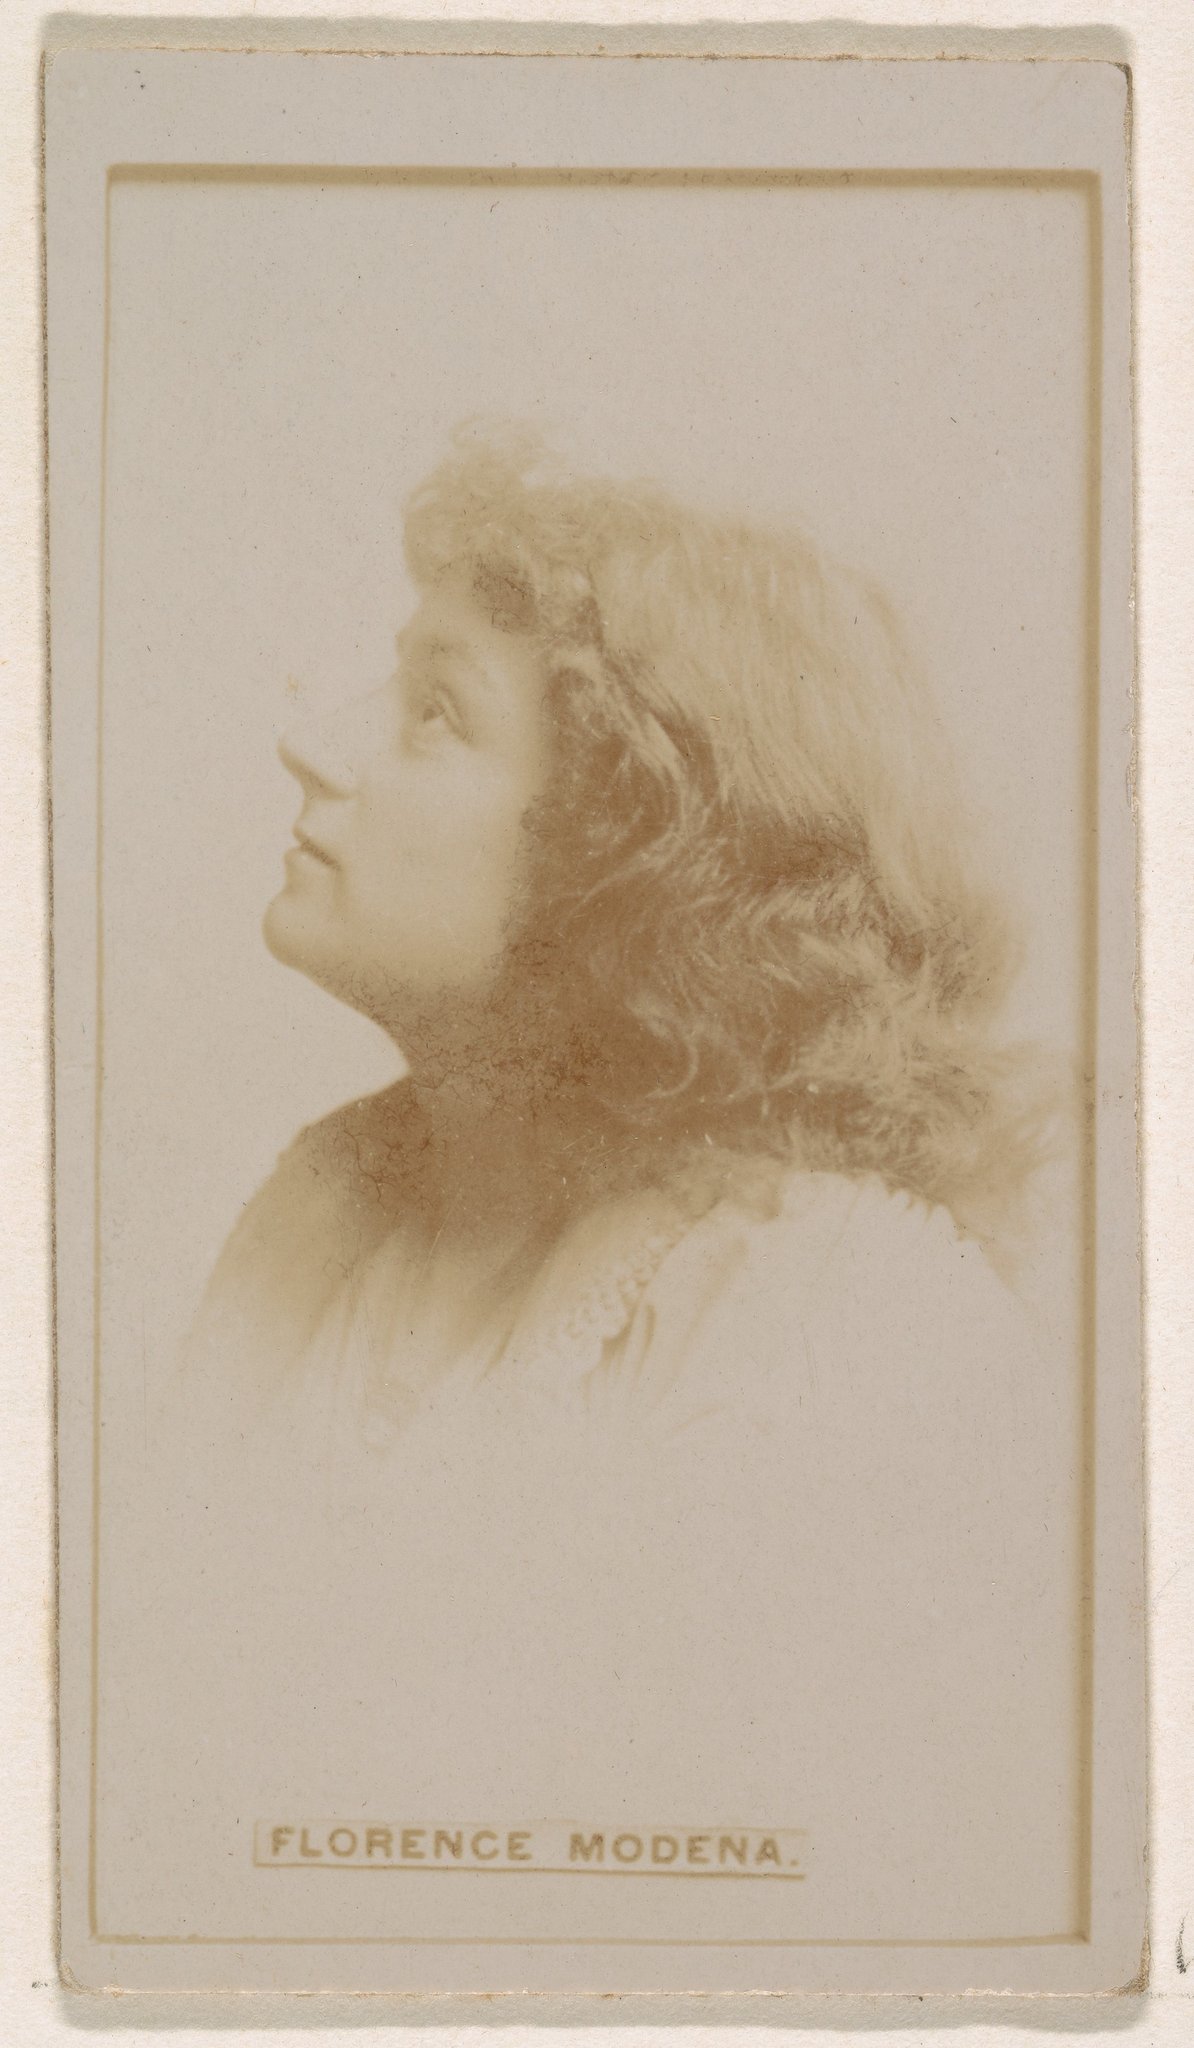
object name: photograph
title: Florence Modena, from the Actresses series (N245) issued by Kinney Brothers to promote Sweet Caporal Cigarettes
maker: kinney brothers tobacco company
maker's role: publisher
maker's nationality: american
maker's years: 1869-2011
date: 1890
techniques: albumen silver print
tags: women,actresses